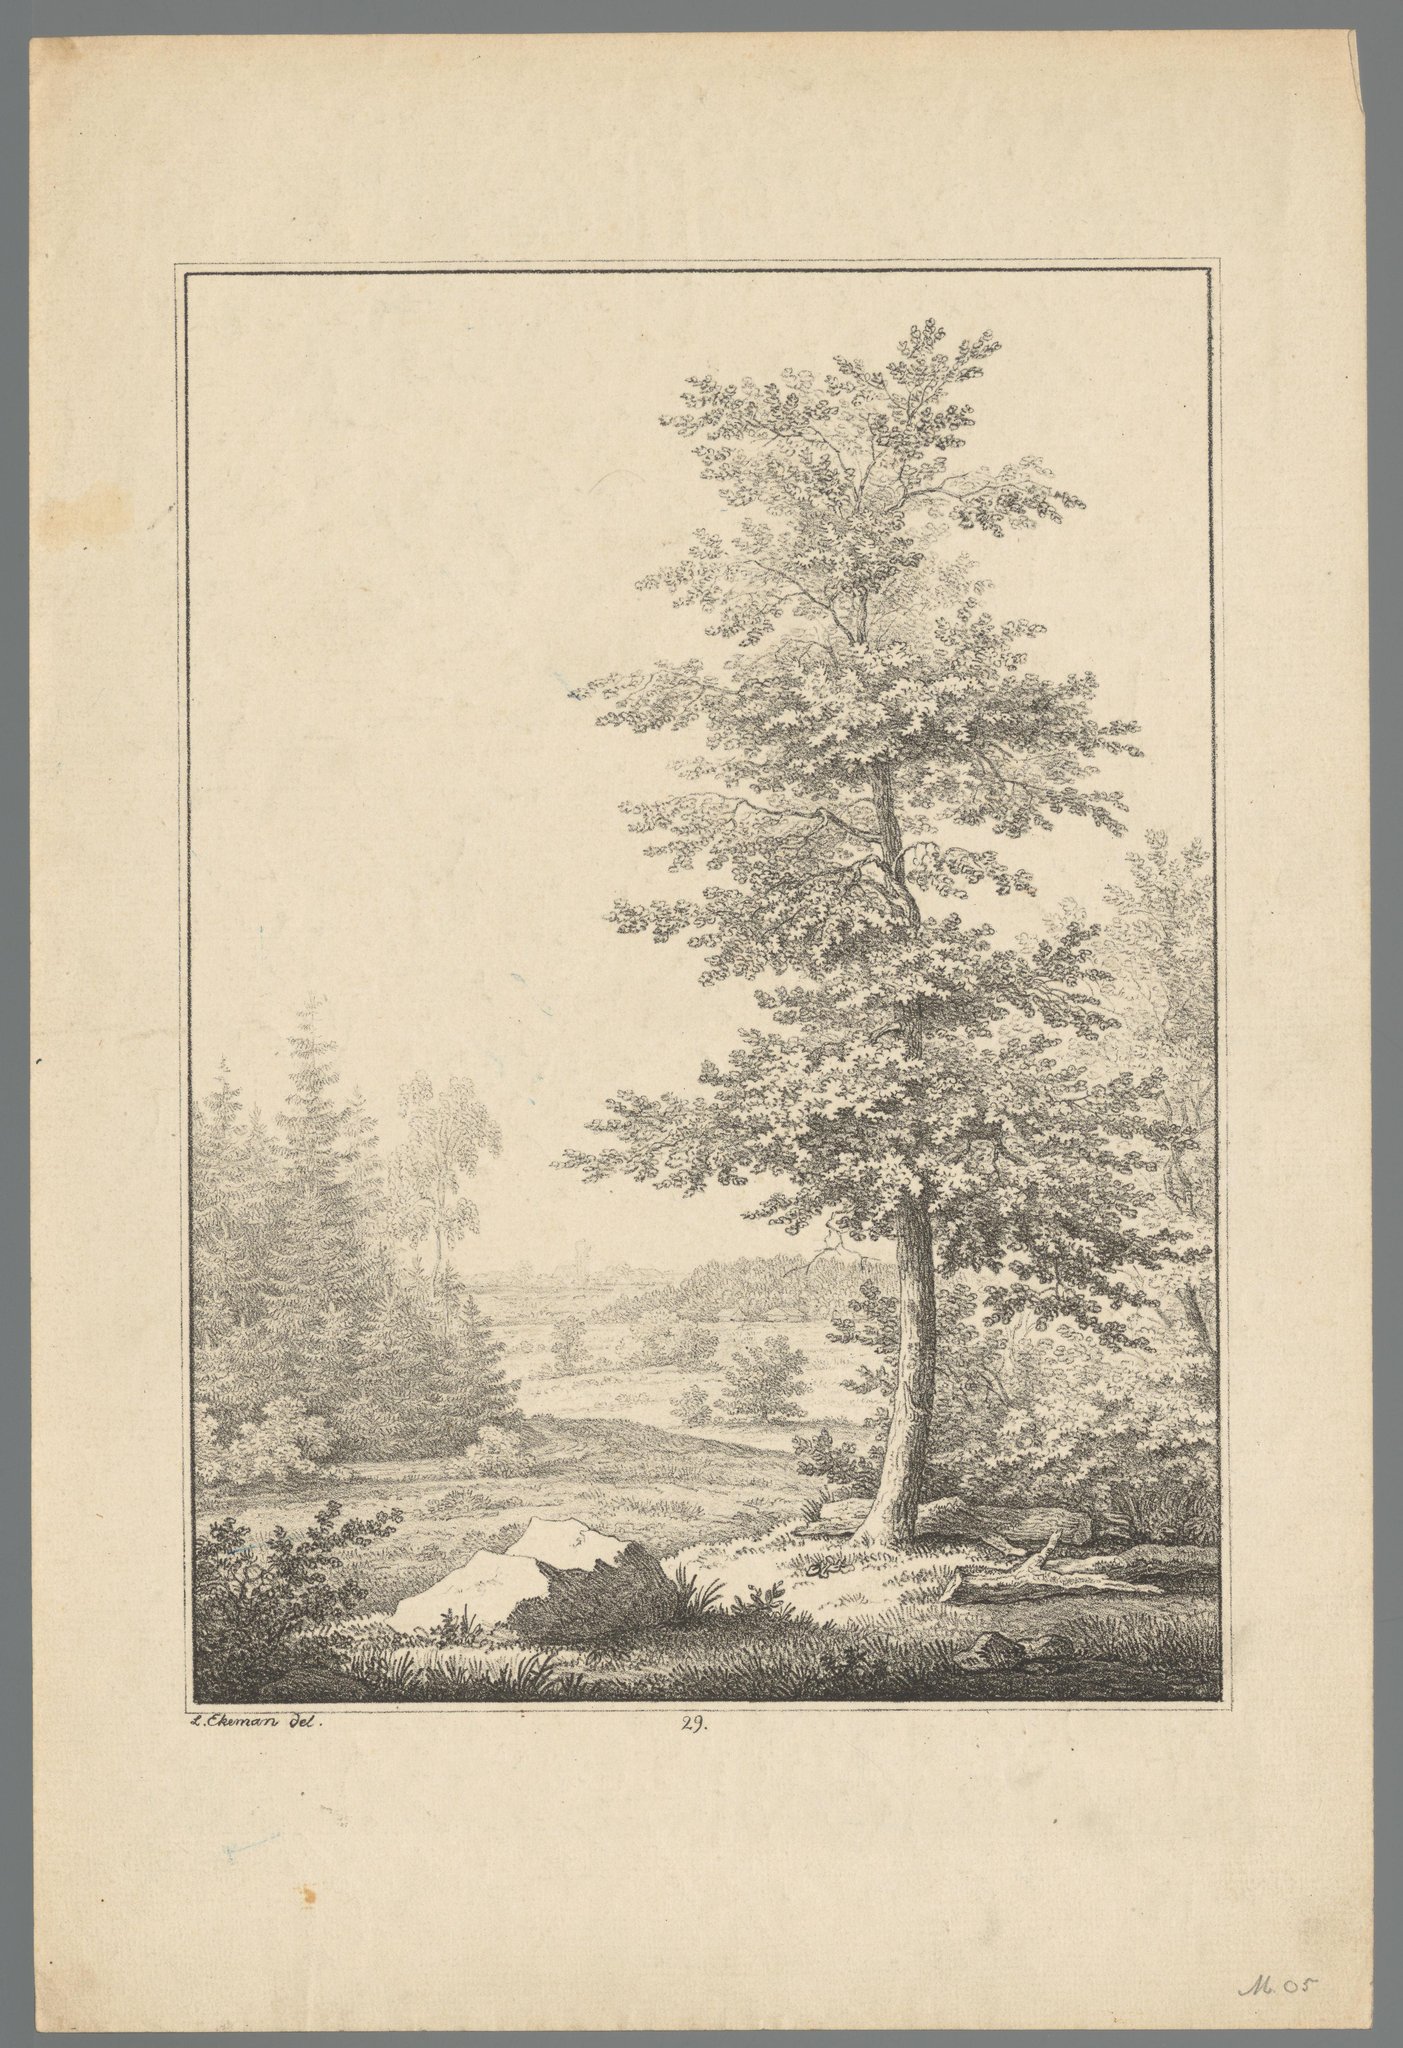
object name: print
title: Boom- en landschapsstudies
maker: lorenz ekeman-allesson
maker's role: print maker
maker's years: 1791-1828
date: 1801-1828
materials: paper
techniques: lithograph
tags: trees, landscapes in the temperate zone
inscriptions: collector's mark: Lugt 2228